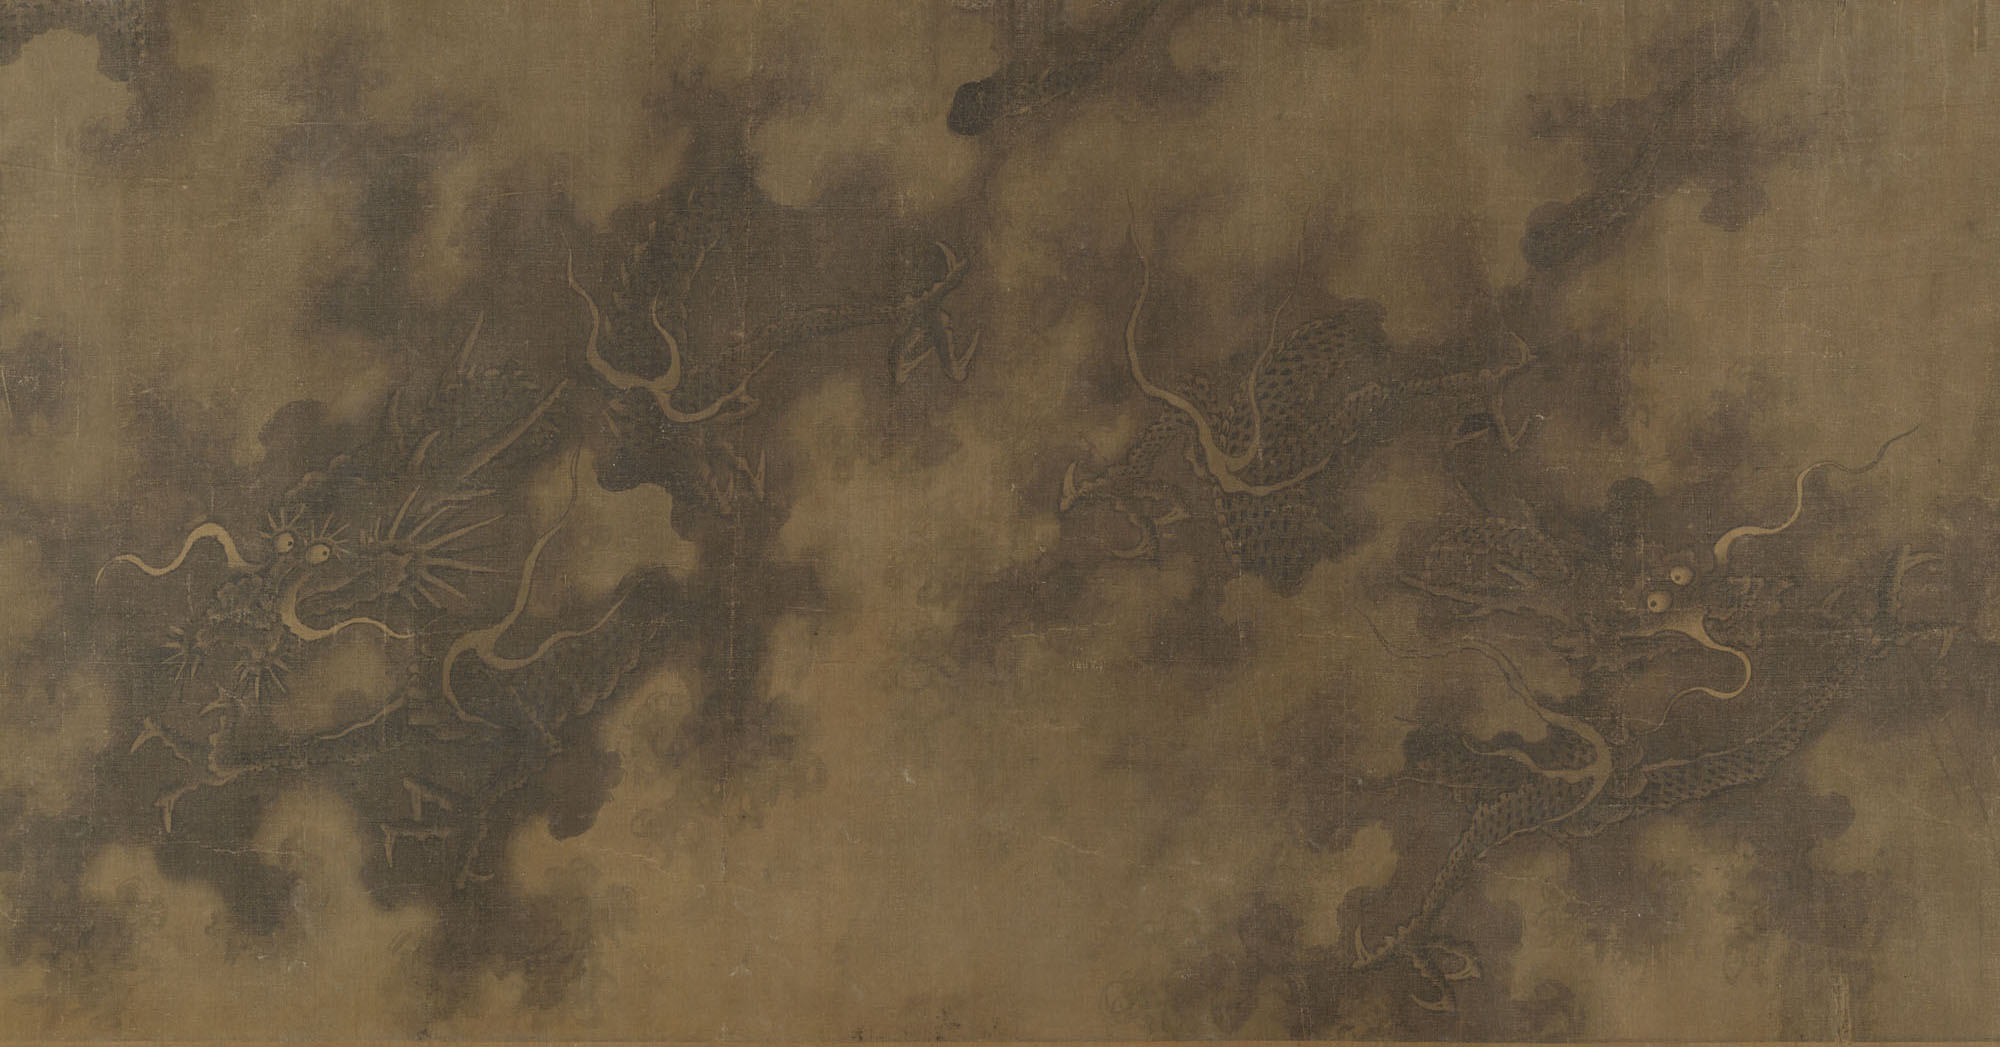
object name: handscroll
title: Nine Dragons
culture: chinese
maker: unidentified artist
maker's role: artist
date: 1601-1700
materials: ink, silk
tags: dragons